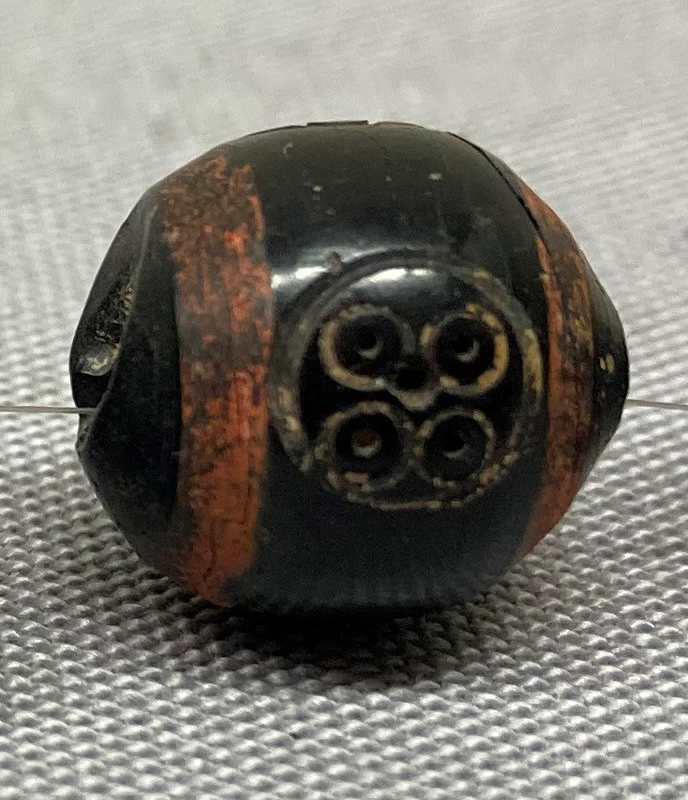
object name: bead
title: Stone Beads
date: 701-1200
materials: stone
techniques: incising, painting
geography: iran